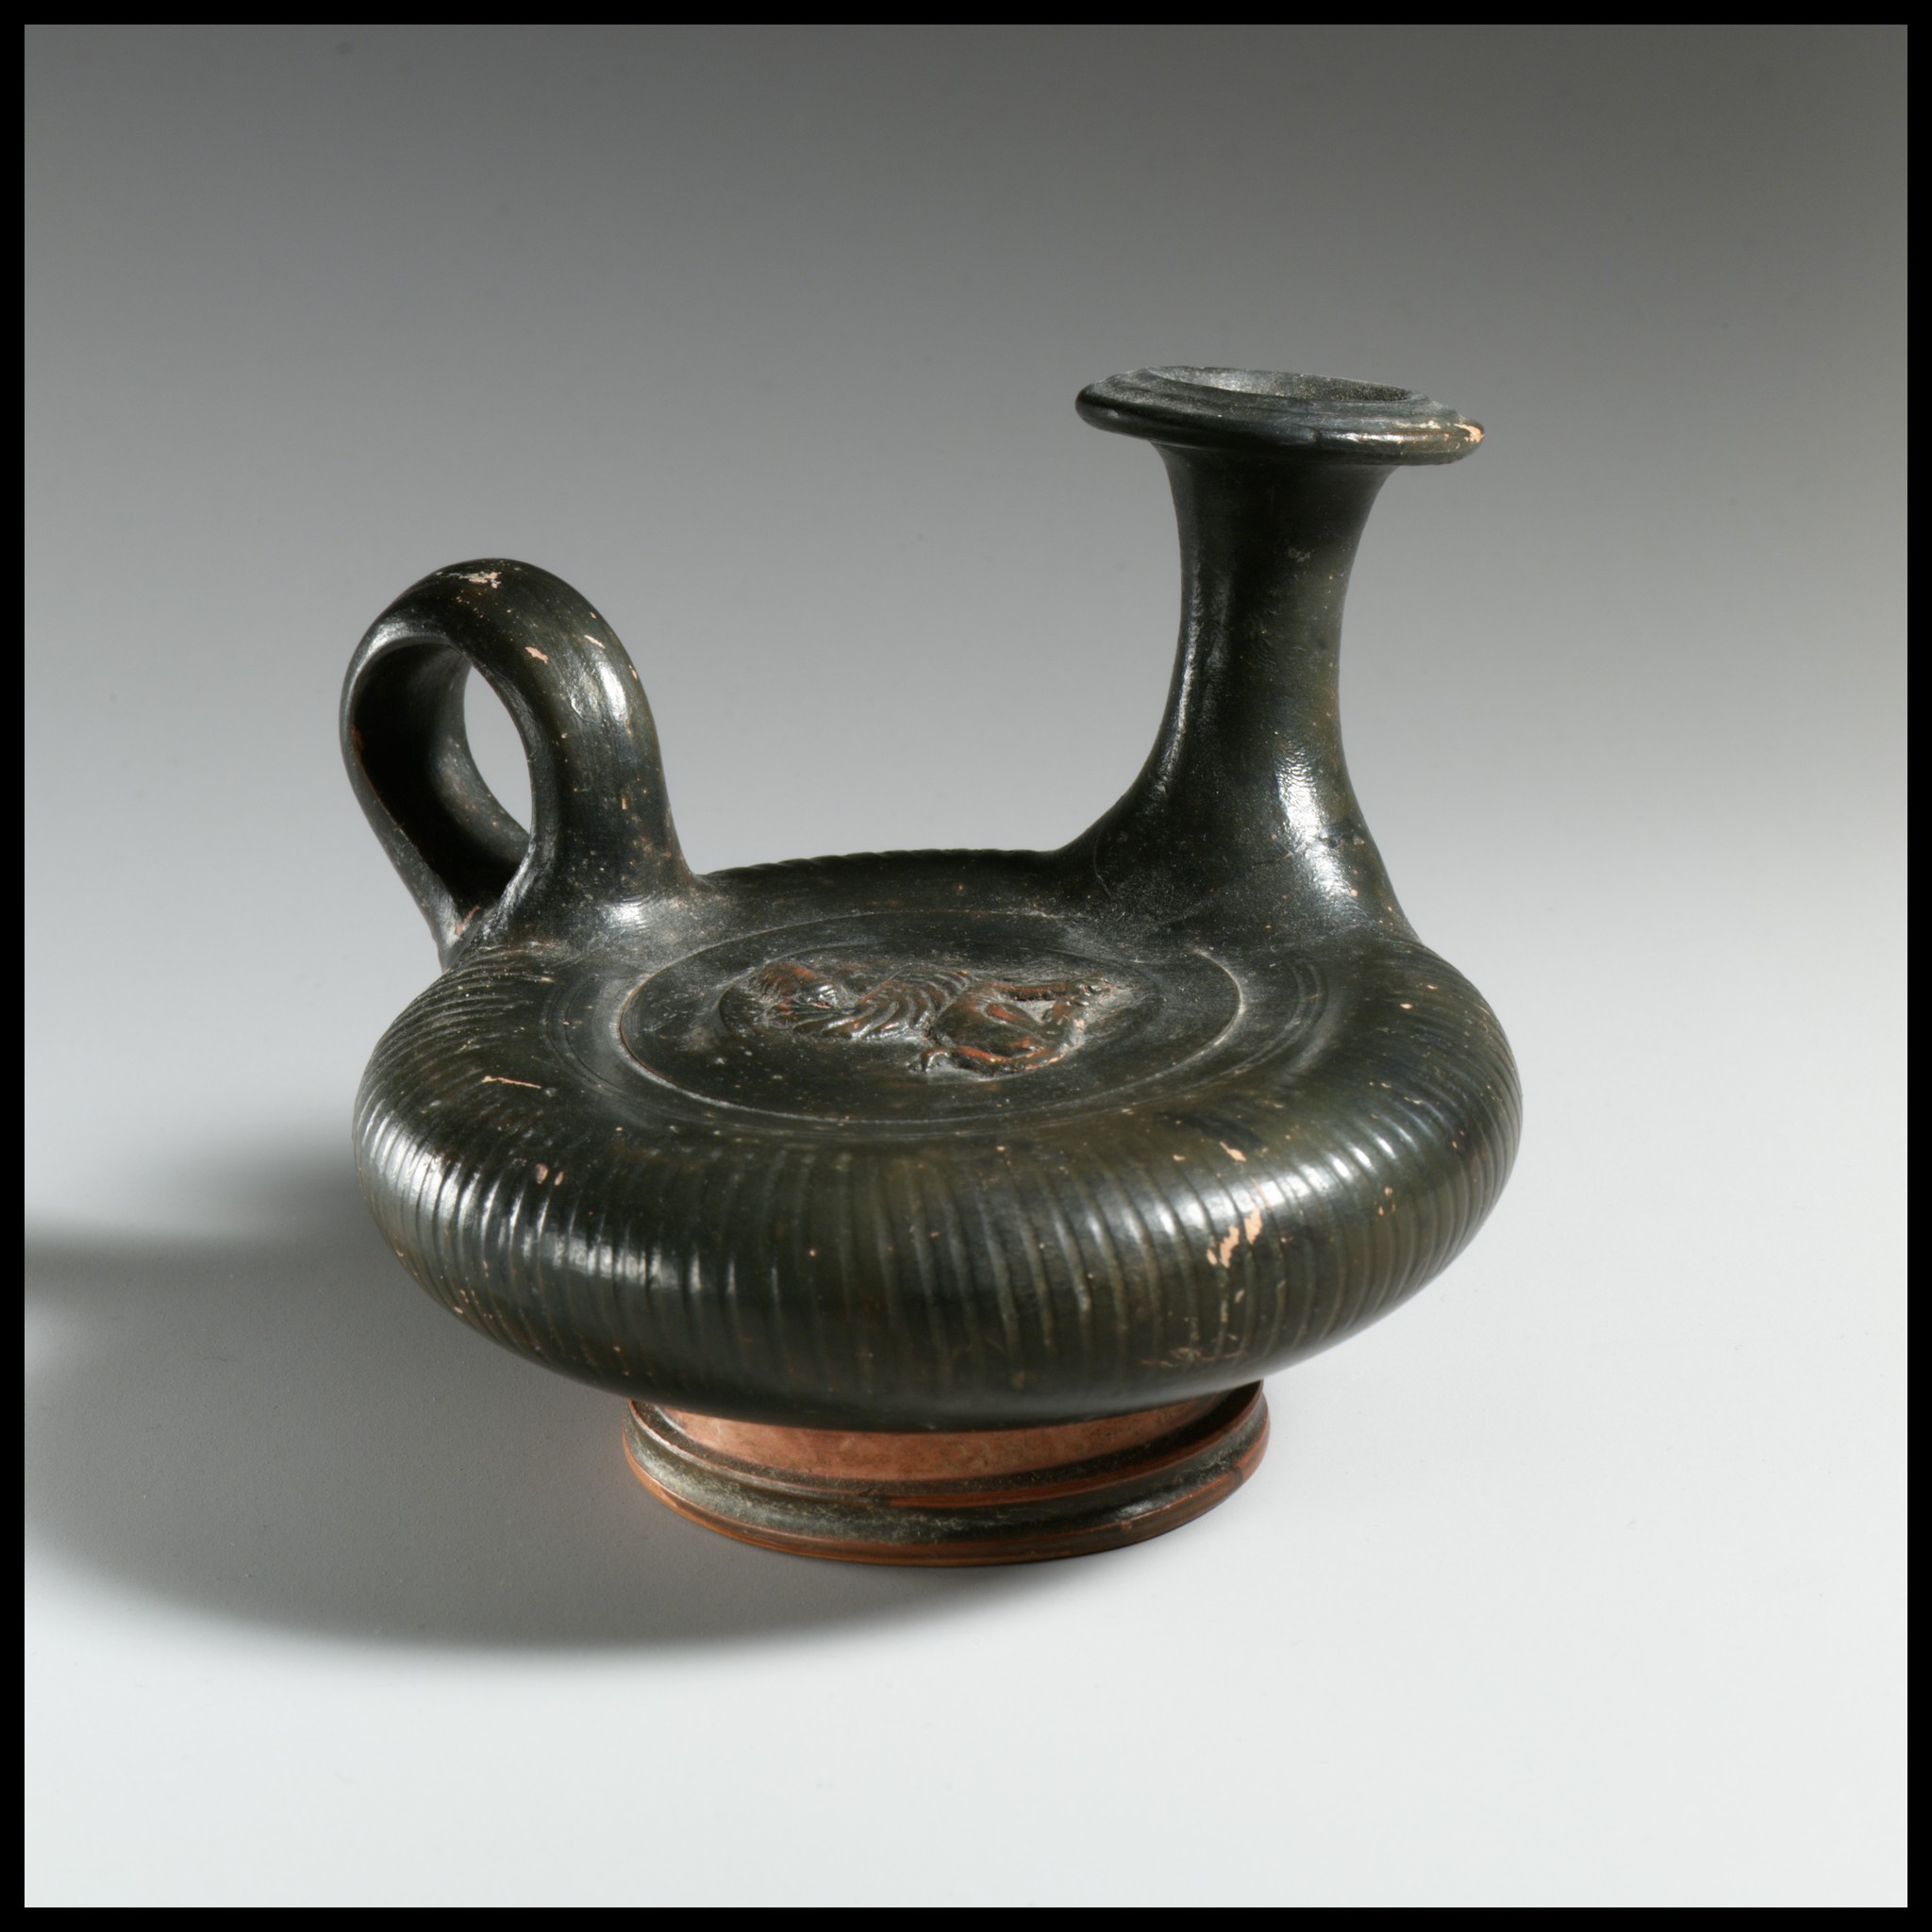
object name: guttus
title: Terracotta guttus (flask with handle and verticle spout)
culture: greek or south italian or campanian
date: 300-201 BCE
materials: terracotta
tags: sphinx